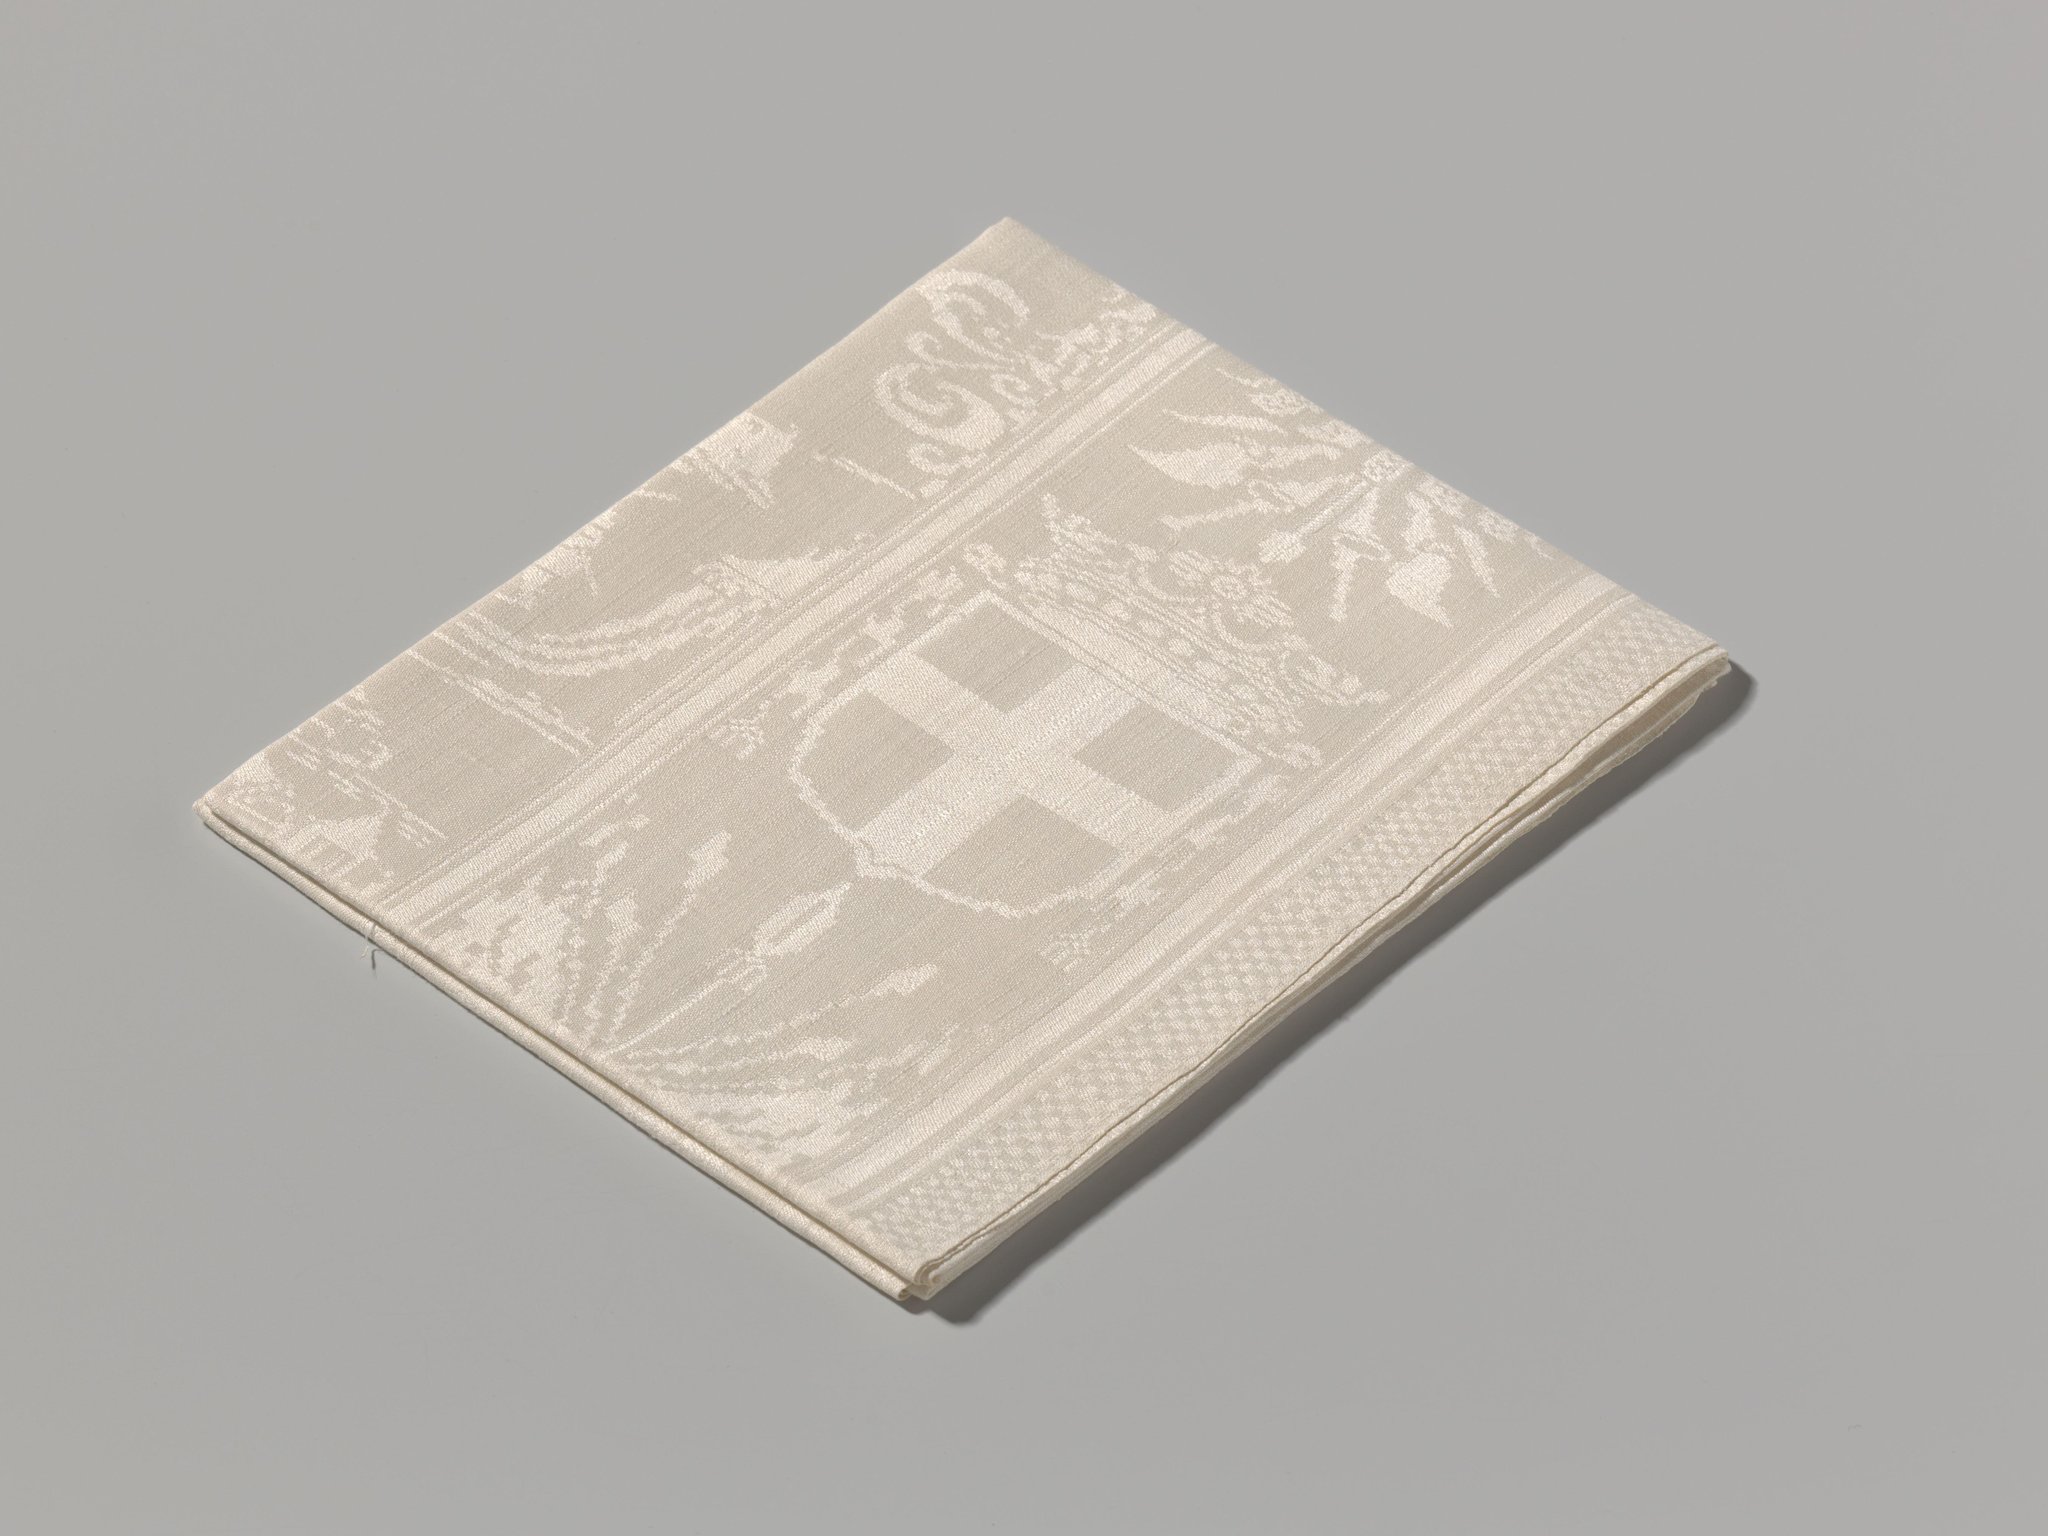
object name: napkin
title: Servet met het wapen van Karel III van Spanje en een gezicht op Rijssel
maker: Anonymous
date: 1702-1713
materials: linen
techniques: damask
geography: kortrijk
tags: vienna, charles vi (holy roman emperor), lille, spain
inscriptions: mark: ‘13’, mark: ‘? S’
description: Servet van linnendamast met het wapen van Karel III van Spanje en een gezicht op Rijssel. Het symmetrisch patroon vertoont van onder naar boven de volgende taferelen: 1 Een gezicht op Rijssel met vele torens. 2 Plattegrond van een vesting met bovenschrift LILLE. 3 Ruiter te paard (Karel III van Spanje?). 4 Het wapen van Karel III van Spanje geflankeerd door vaandels. Staande en liggende randen: wapens, onder andere Savoye, en wapentrofeeën; daarbuiten: blokkenrand.